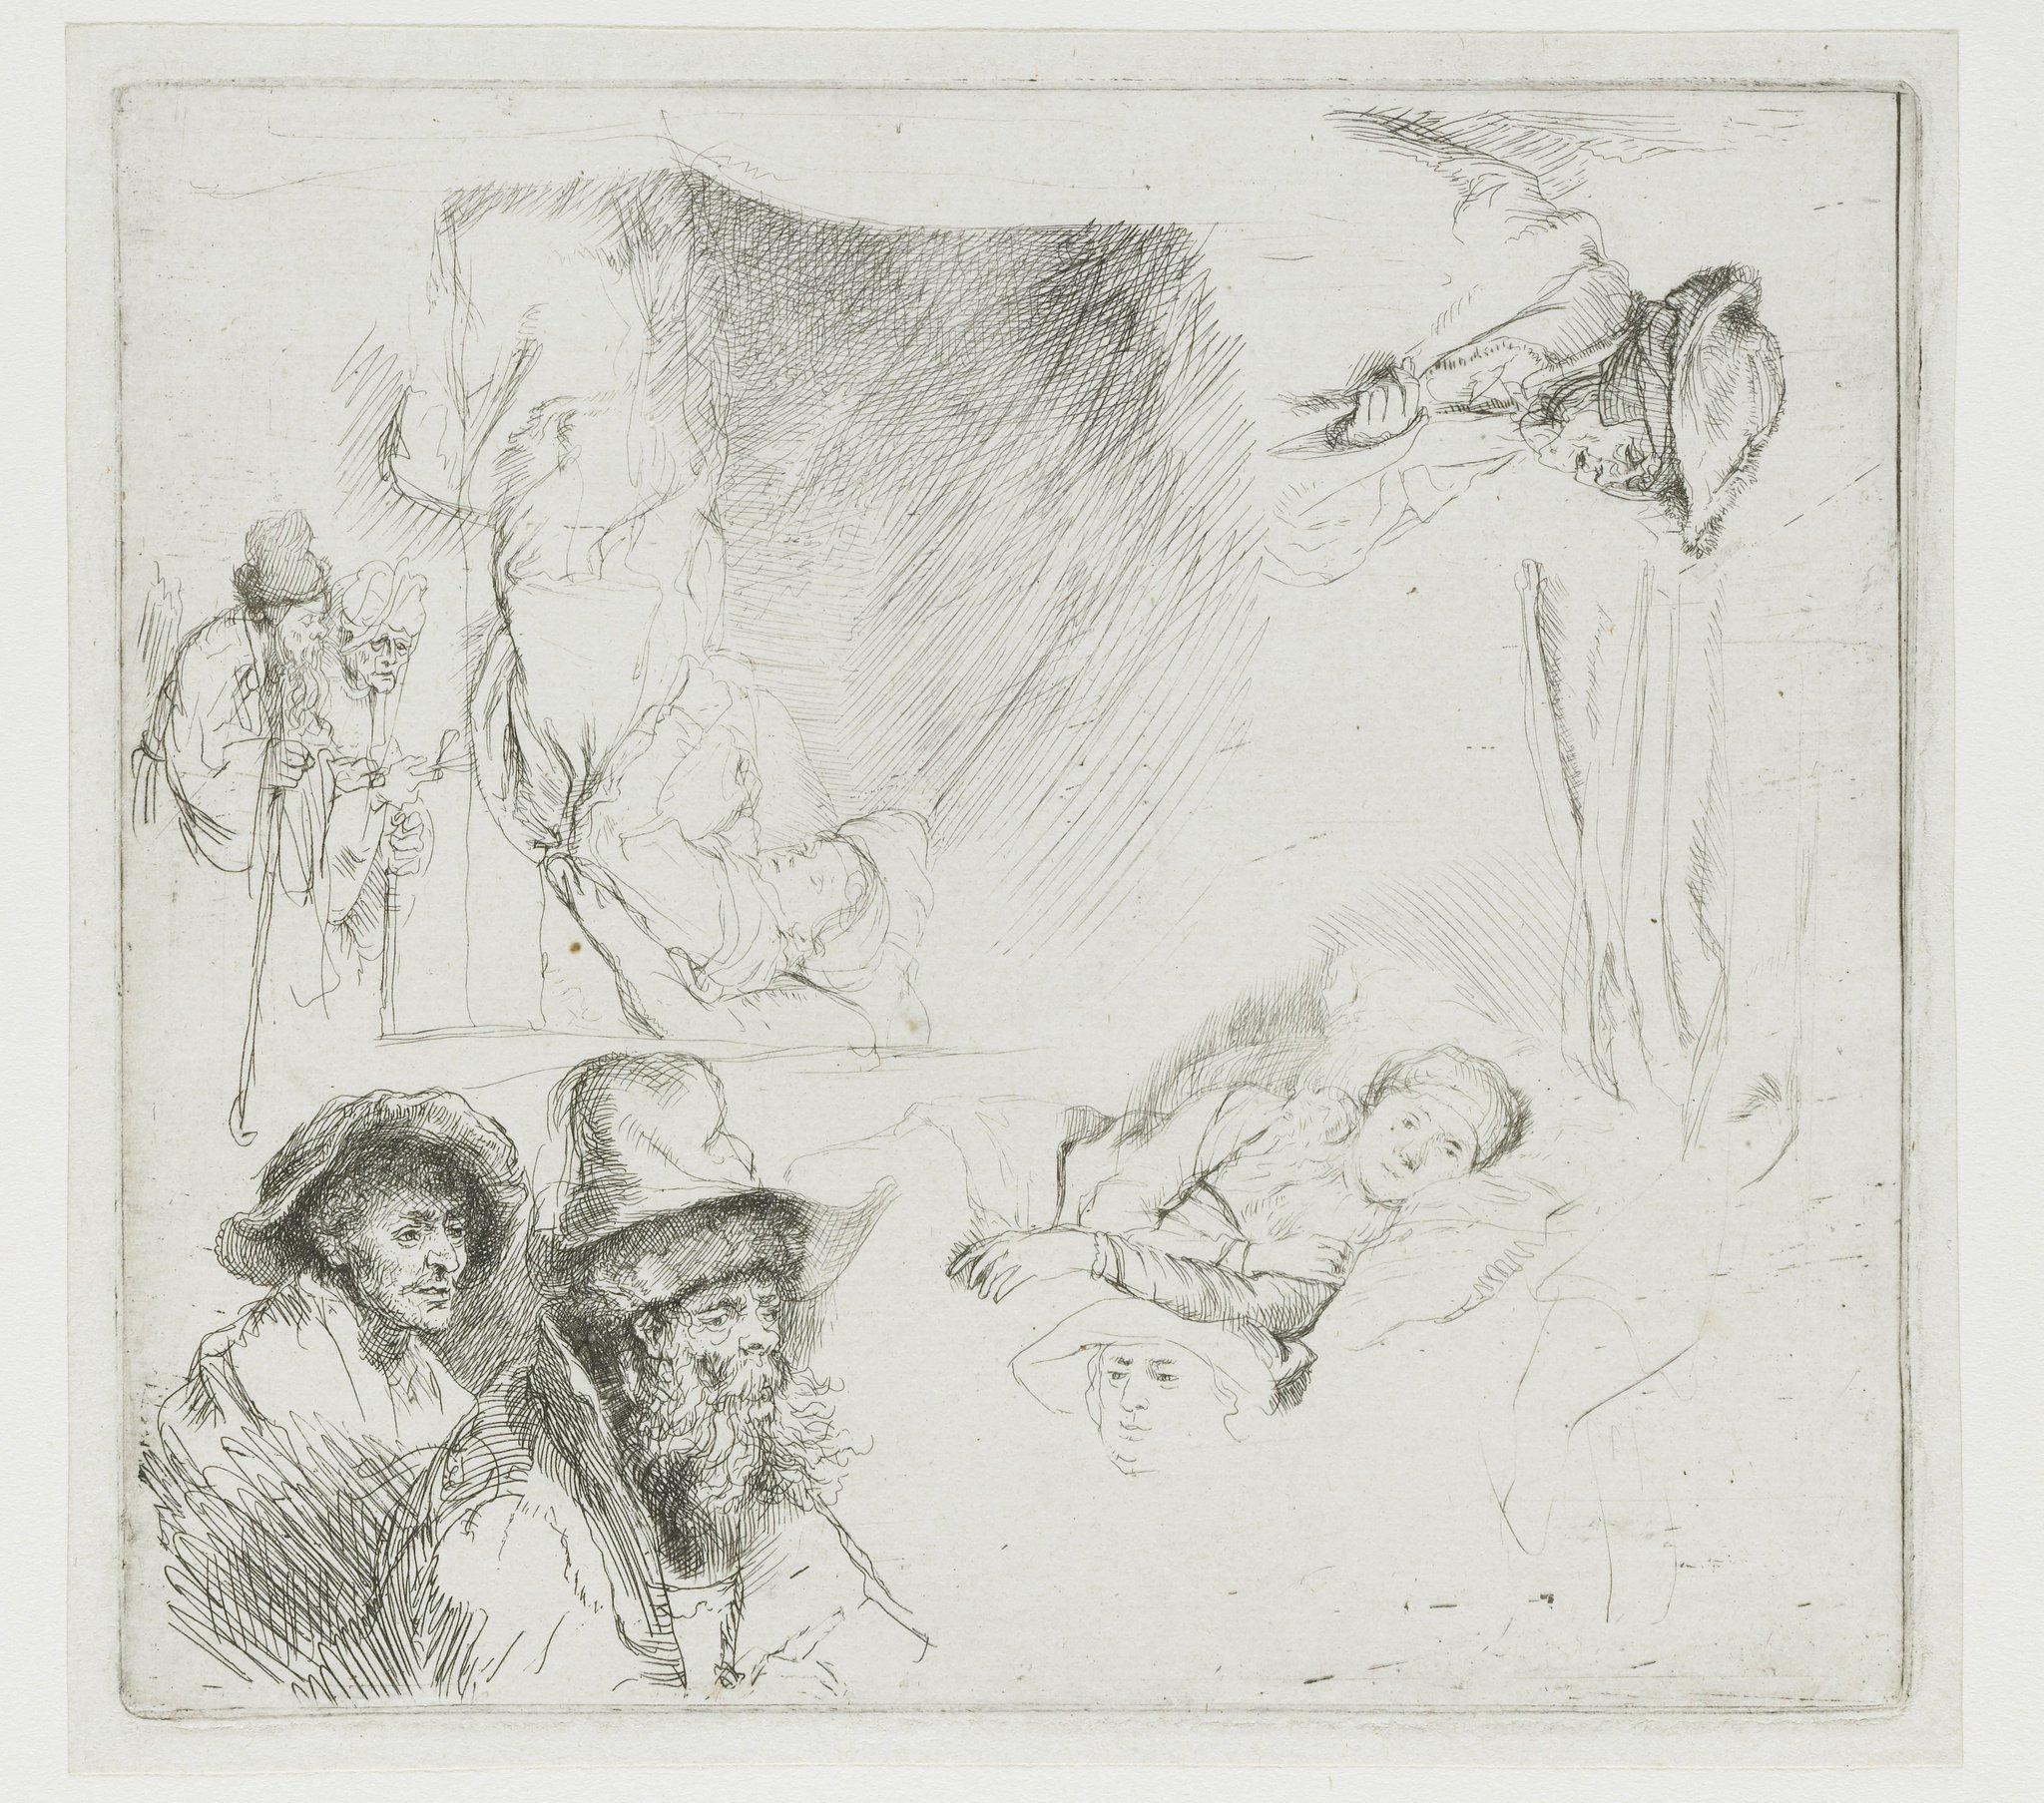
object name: print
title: Sheet of studies, with a woman lying ill in bed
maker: rembrandt van rijn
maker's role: draughtsman, painter, print maker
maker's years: 1606-1669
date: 1639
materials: paper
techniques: etching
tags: sick-bed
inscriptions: collector's mark: Lugt 240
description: Along with other motifs, a woman, depicted twice, can be seen in this sheet. She lies in bed, in one instance sleeping, and in the other staring out listlessly. This must be Saskia, who was deathly ill in 1641. The frequency with which Rembrandt portrayed her leaves no doubts that he was deeply concerned about her condition.